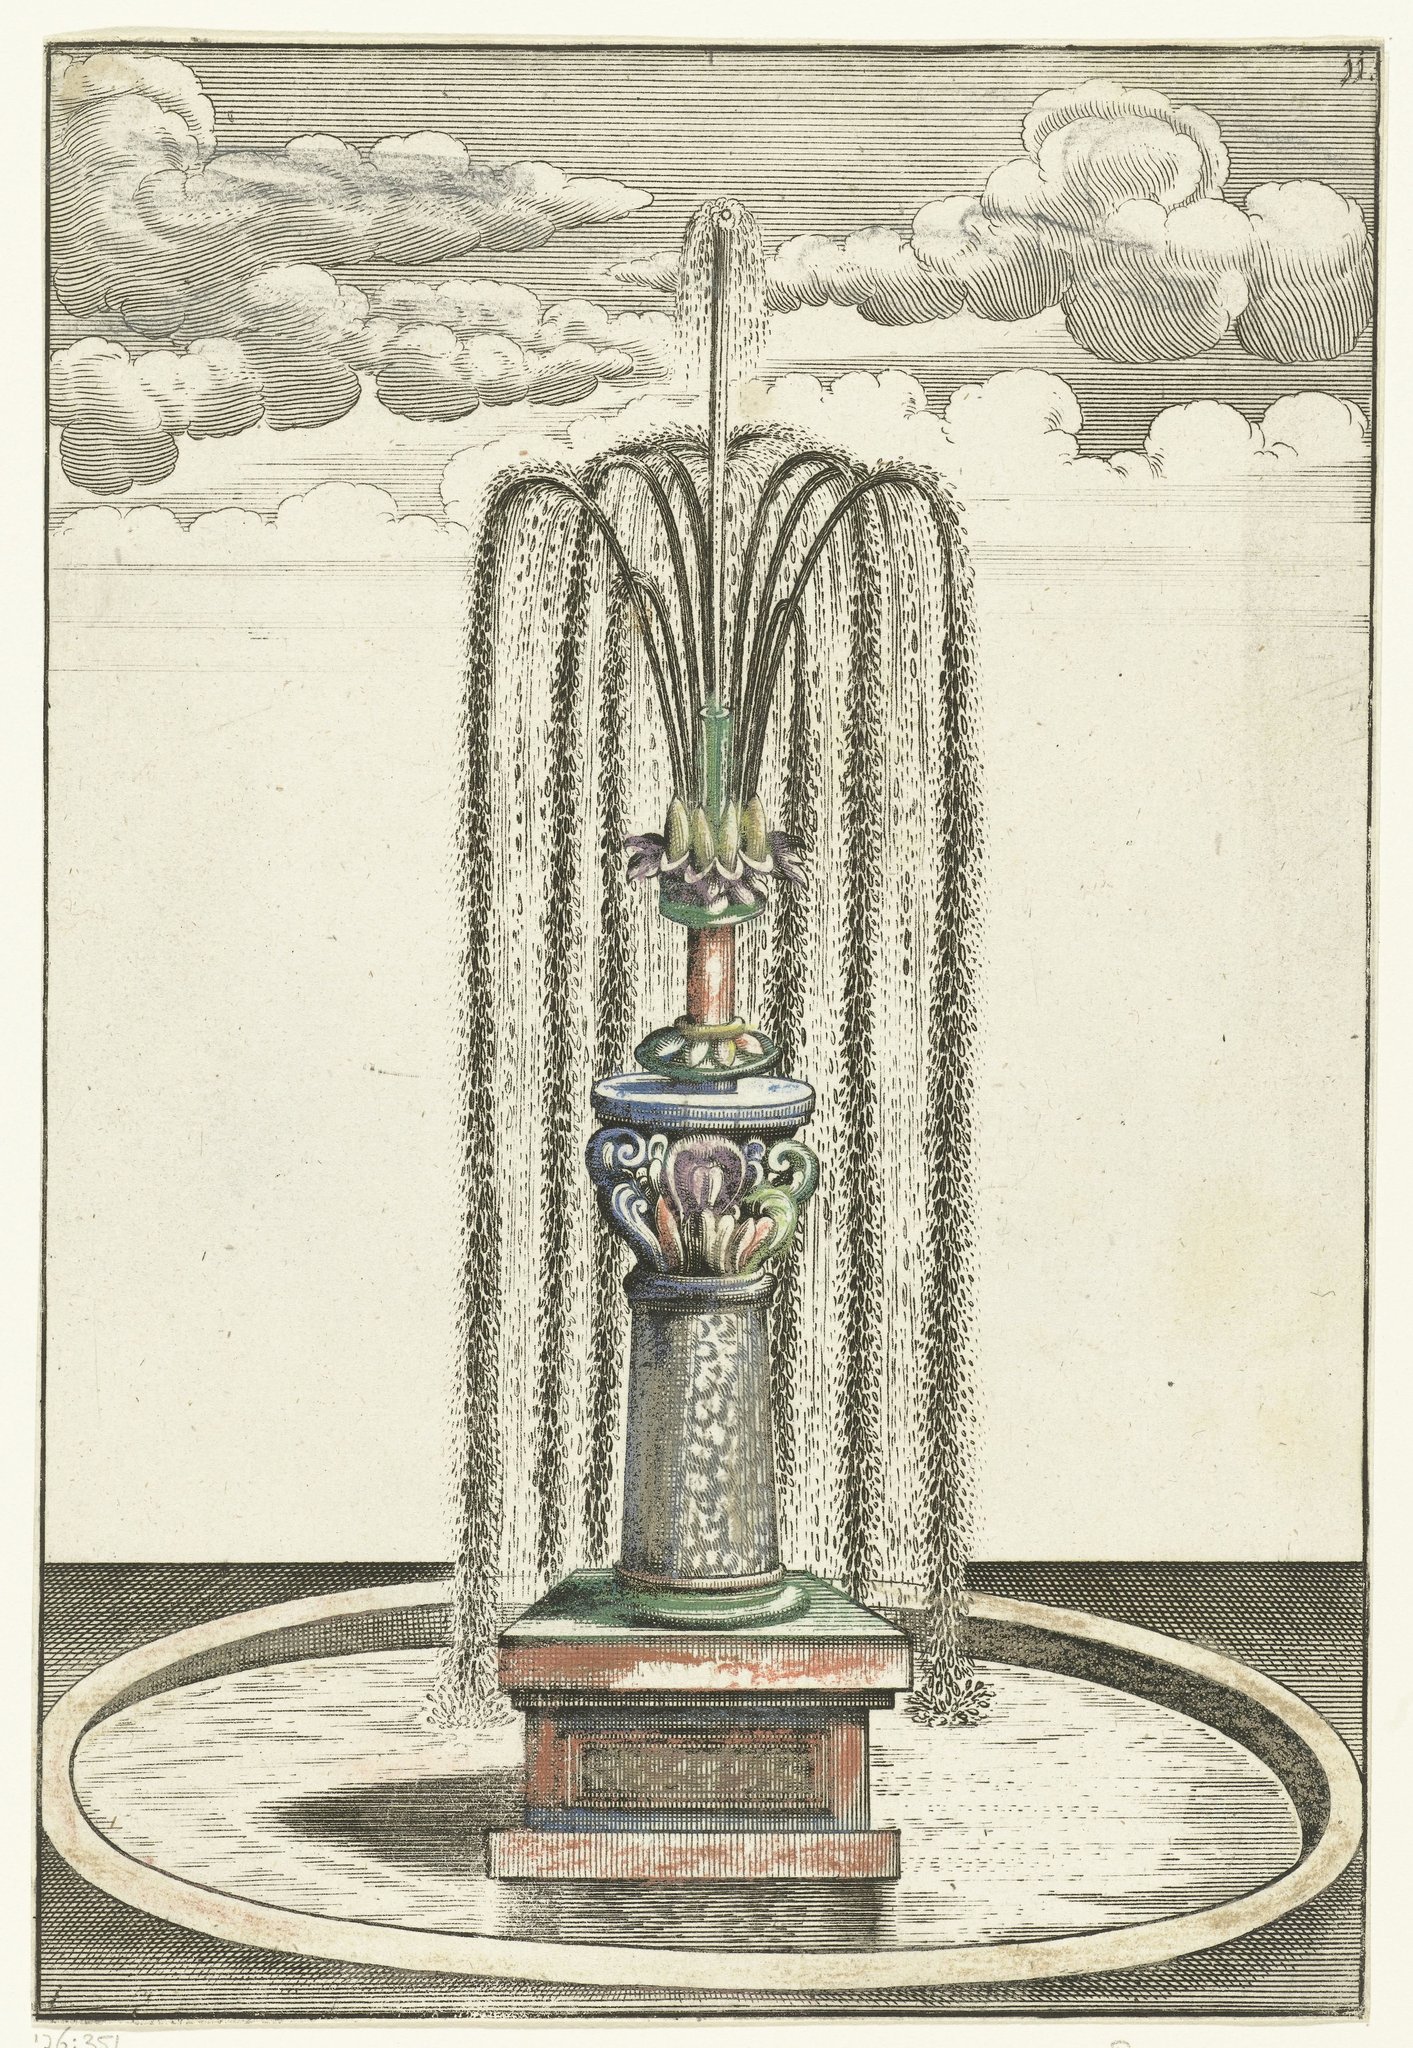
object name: print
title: Rond bassin met korte zuil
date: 1664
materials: paper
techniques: etching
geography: nuremberg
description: De zuil heeft een denkbeeldig kapiteel, het water spuit omhoog via gestileerde bloembladeren die een langere pijp omringen. Blad 11 uit deel III van een serie bestaande uit 226 bladen, verdeeld over vier boeken, elk met een eigen titelblad.